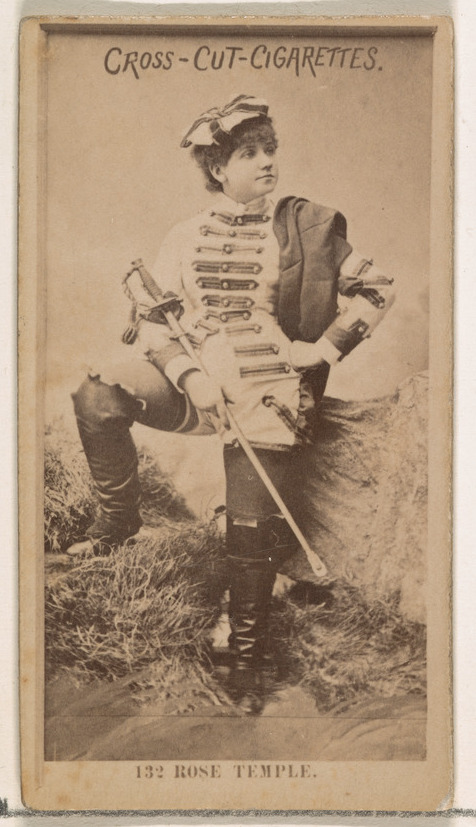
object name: print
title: Card Number 132, Rose Temple, from the Actors and Actresses series (N145-2) issued by Duke Sons & Co. to promote Cross Cut Cigarettes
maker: w. duke, sons & co.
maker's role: publisher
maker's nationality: american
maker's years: 1870-1920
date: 1880-1889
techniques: albumen silver print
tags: portraits,women,actresses